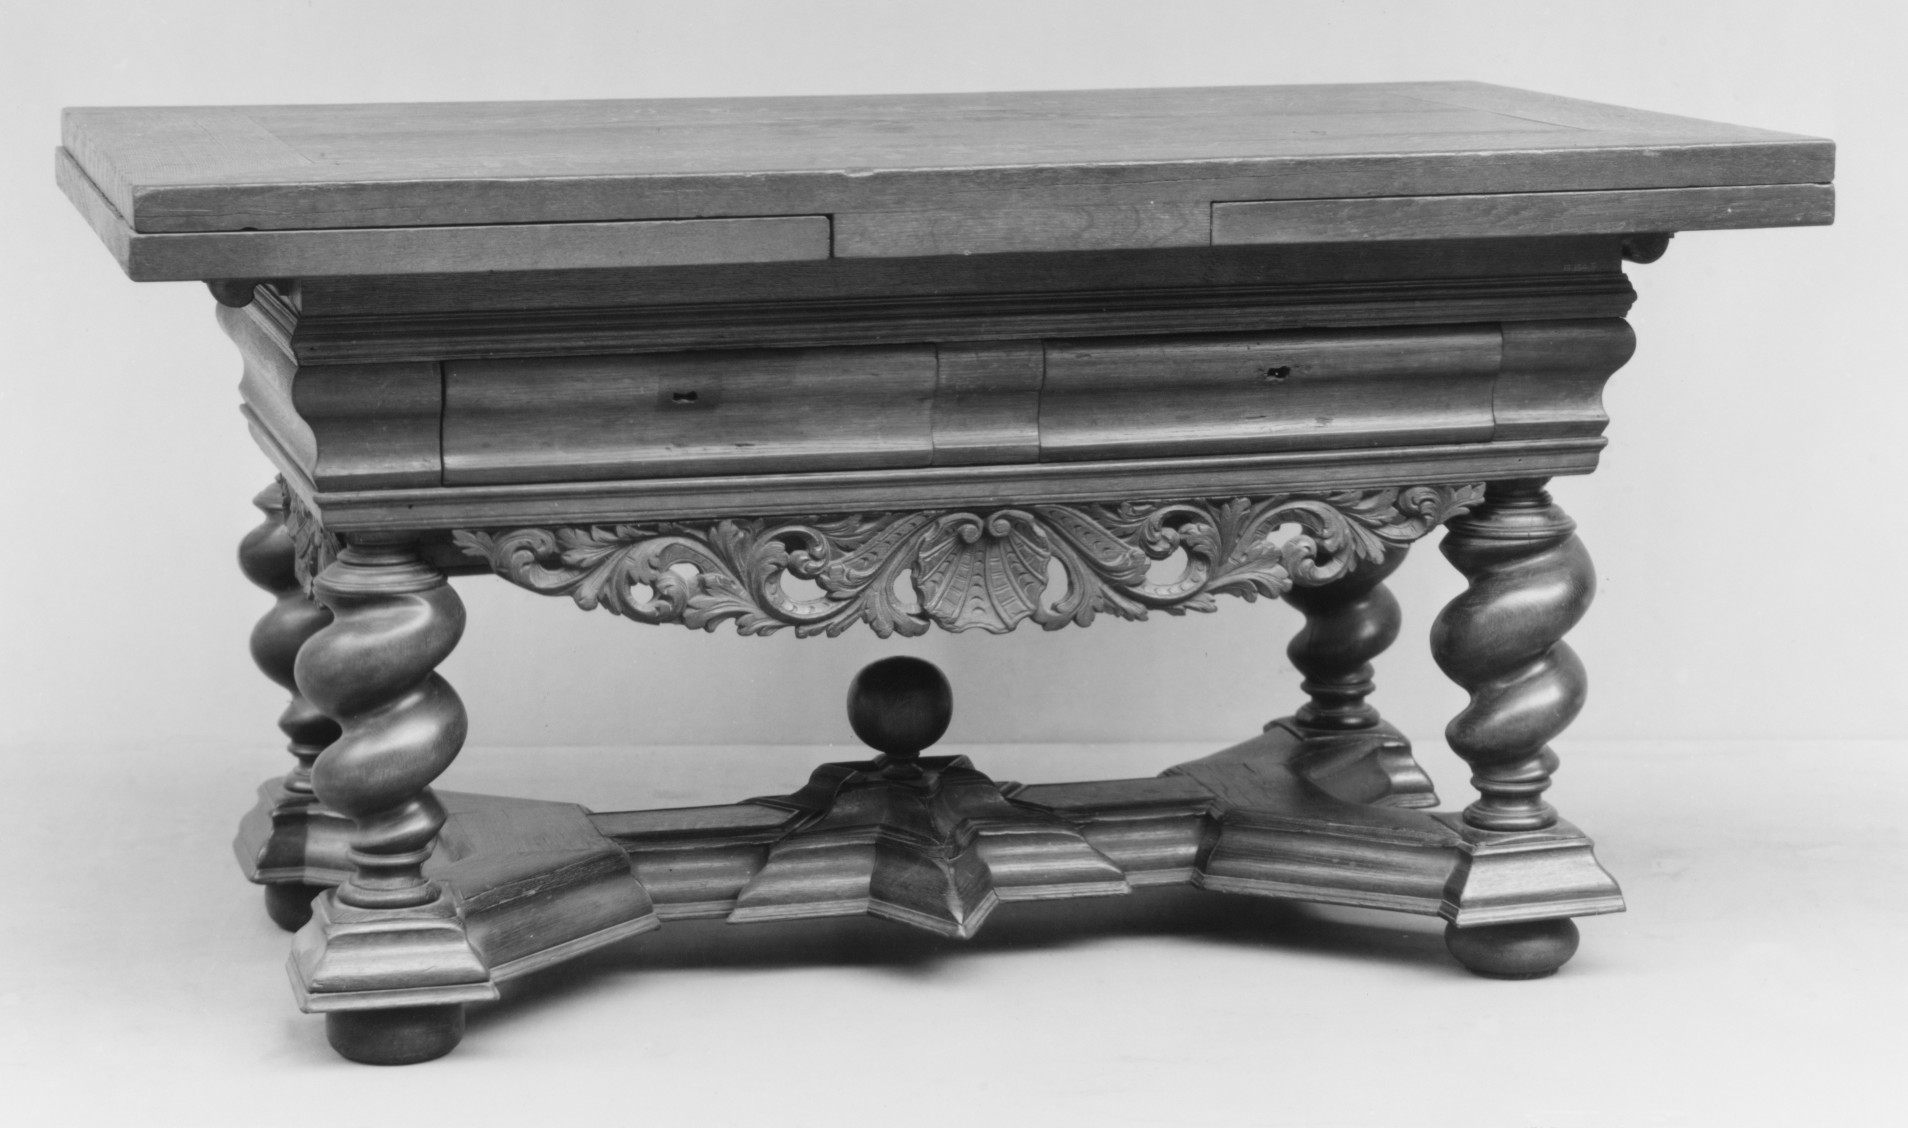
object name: draw top table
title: Draw-top table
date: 1675-1700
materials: wood